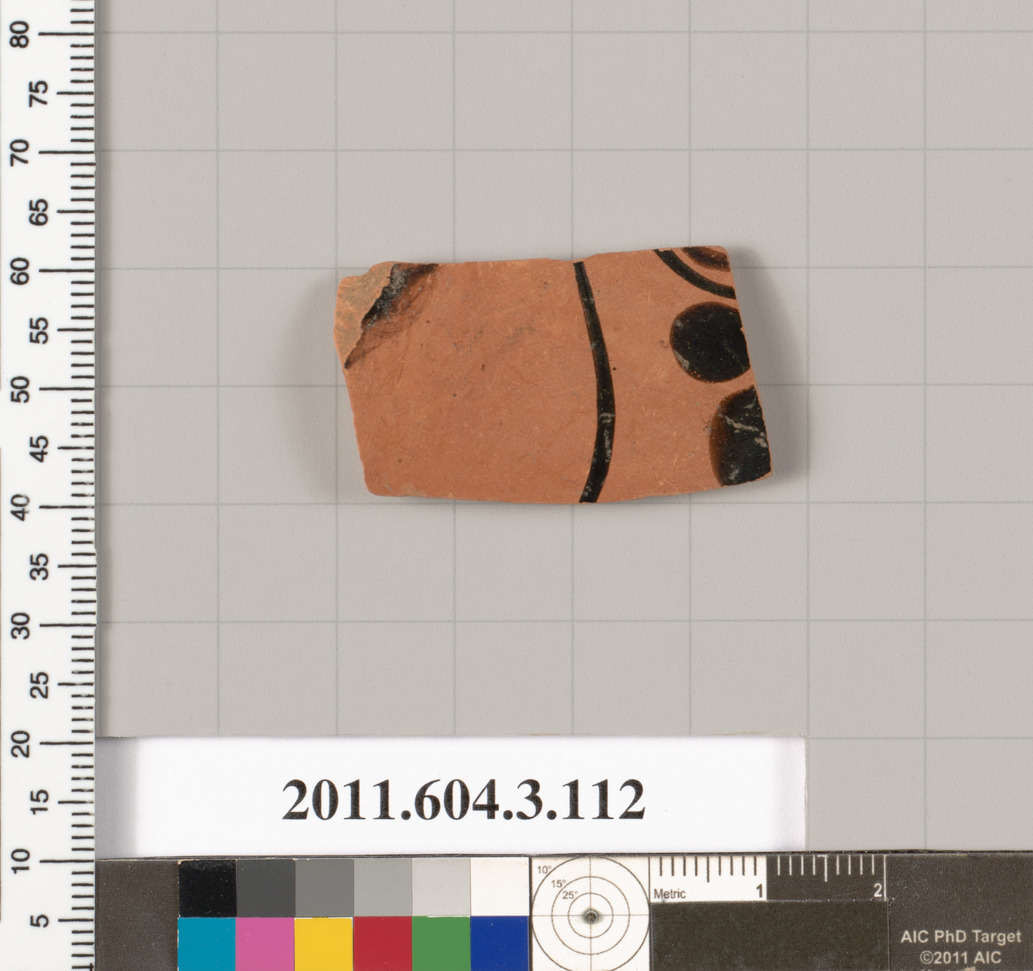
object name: amphora fragment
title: Terracotta fragment of an amphora (jar)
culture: greek, attic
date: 540-530 BCE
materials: terracotta